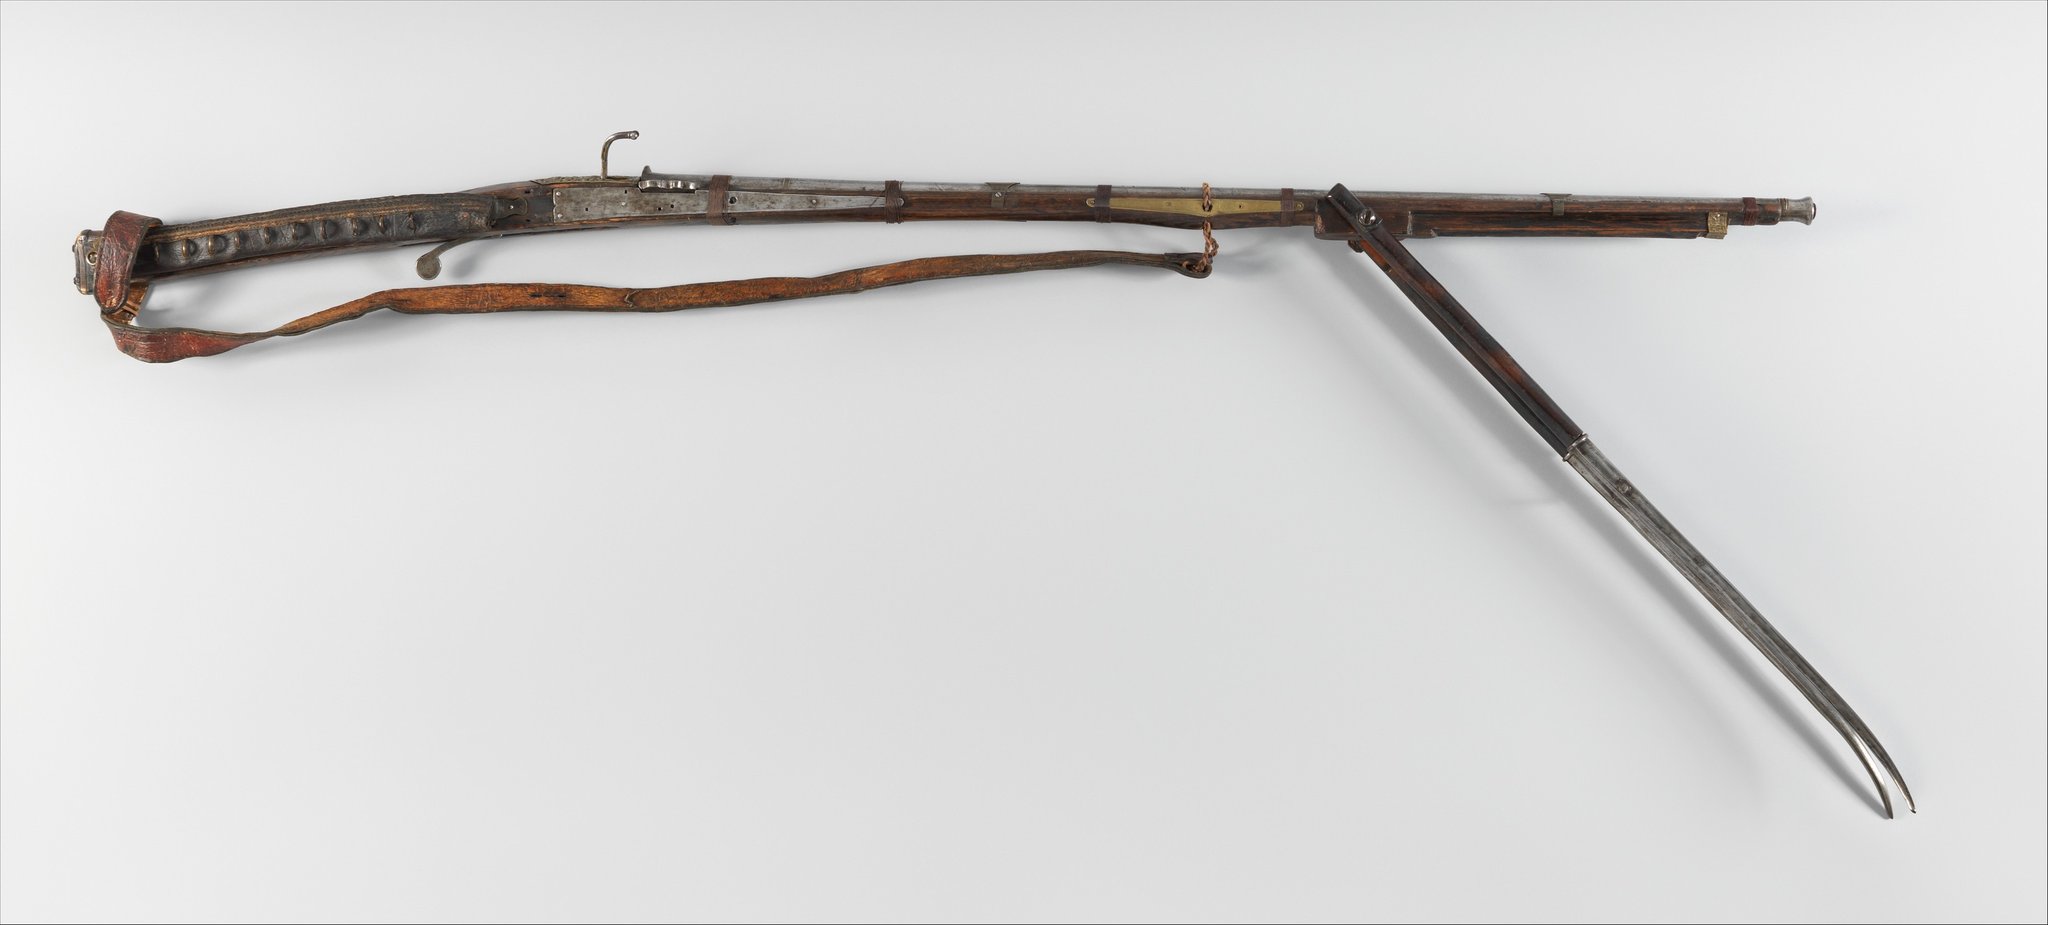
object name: matchlock musket me mda'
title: Matchlock Musket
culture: tibetan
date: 1801-1900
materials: brass, copper, iron, leather, wood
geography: tibet